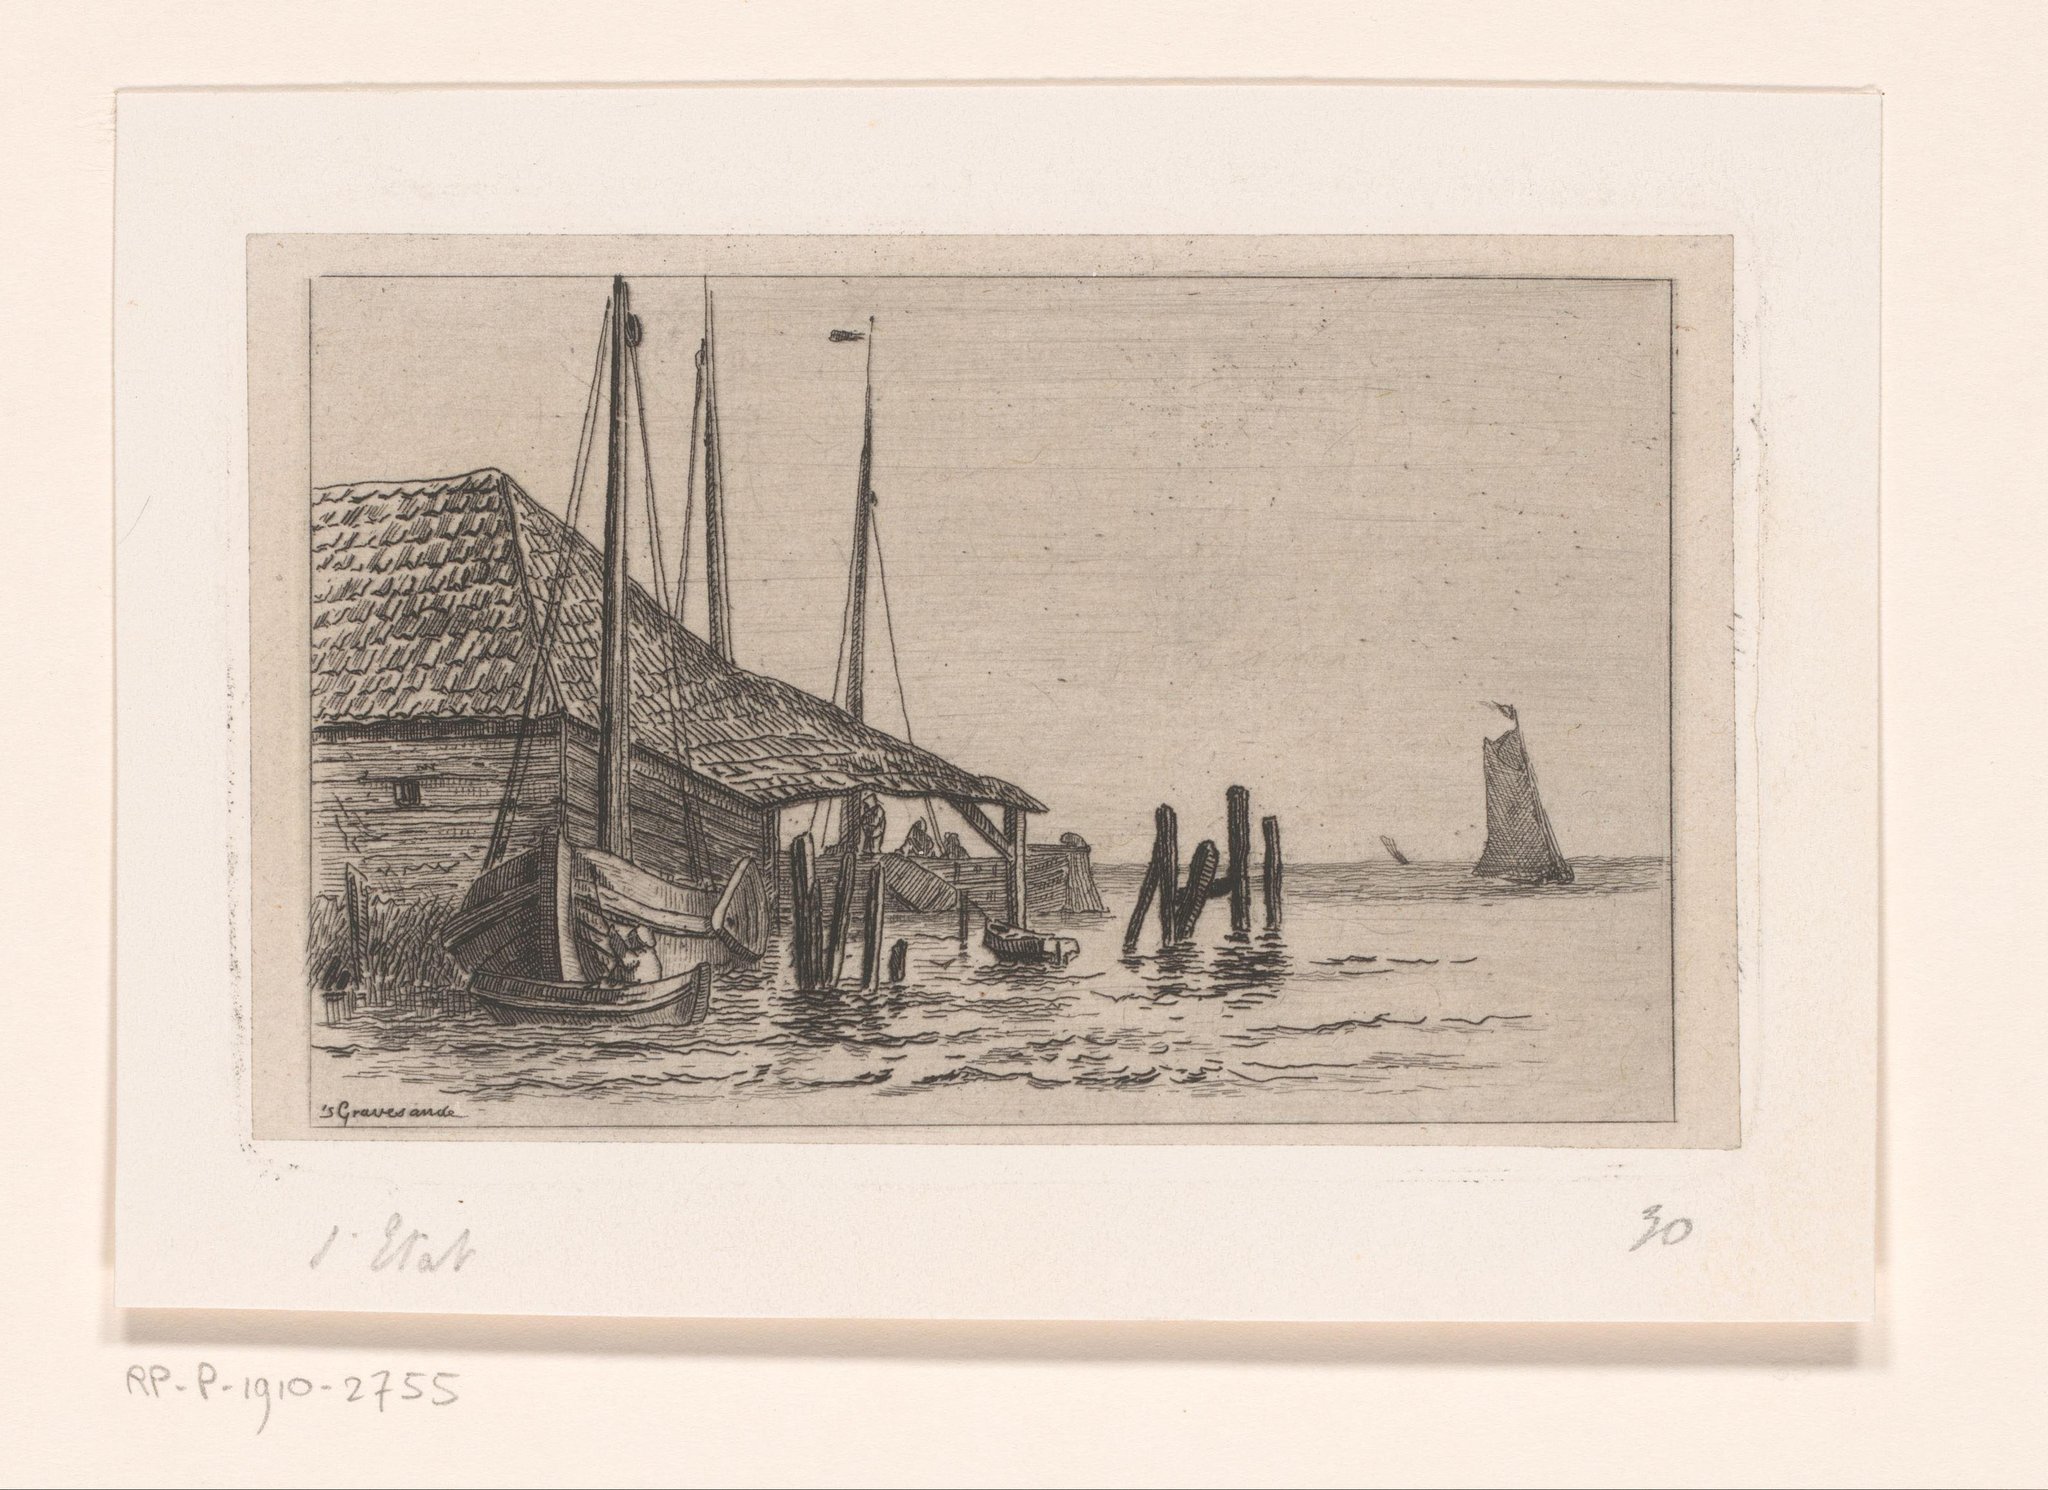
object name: print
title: Gezicht op de Schelde bij Burcht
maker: carel nicolaas storm van s-gravesande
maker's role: draughtsman, print maker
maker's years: 1841-1924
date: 1872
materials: paper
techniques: etching, intaglio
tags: harbour, river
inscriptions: collector's mark: Lugt 2228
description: Links een boothuis, een pier en afgemeerde zeilboten. Rechts vaart een zeilboot.